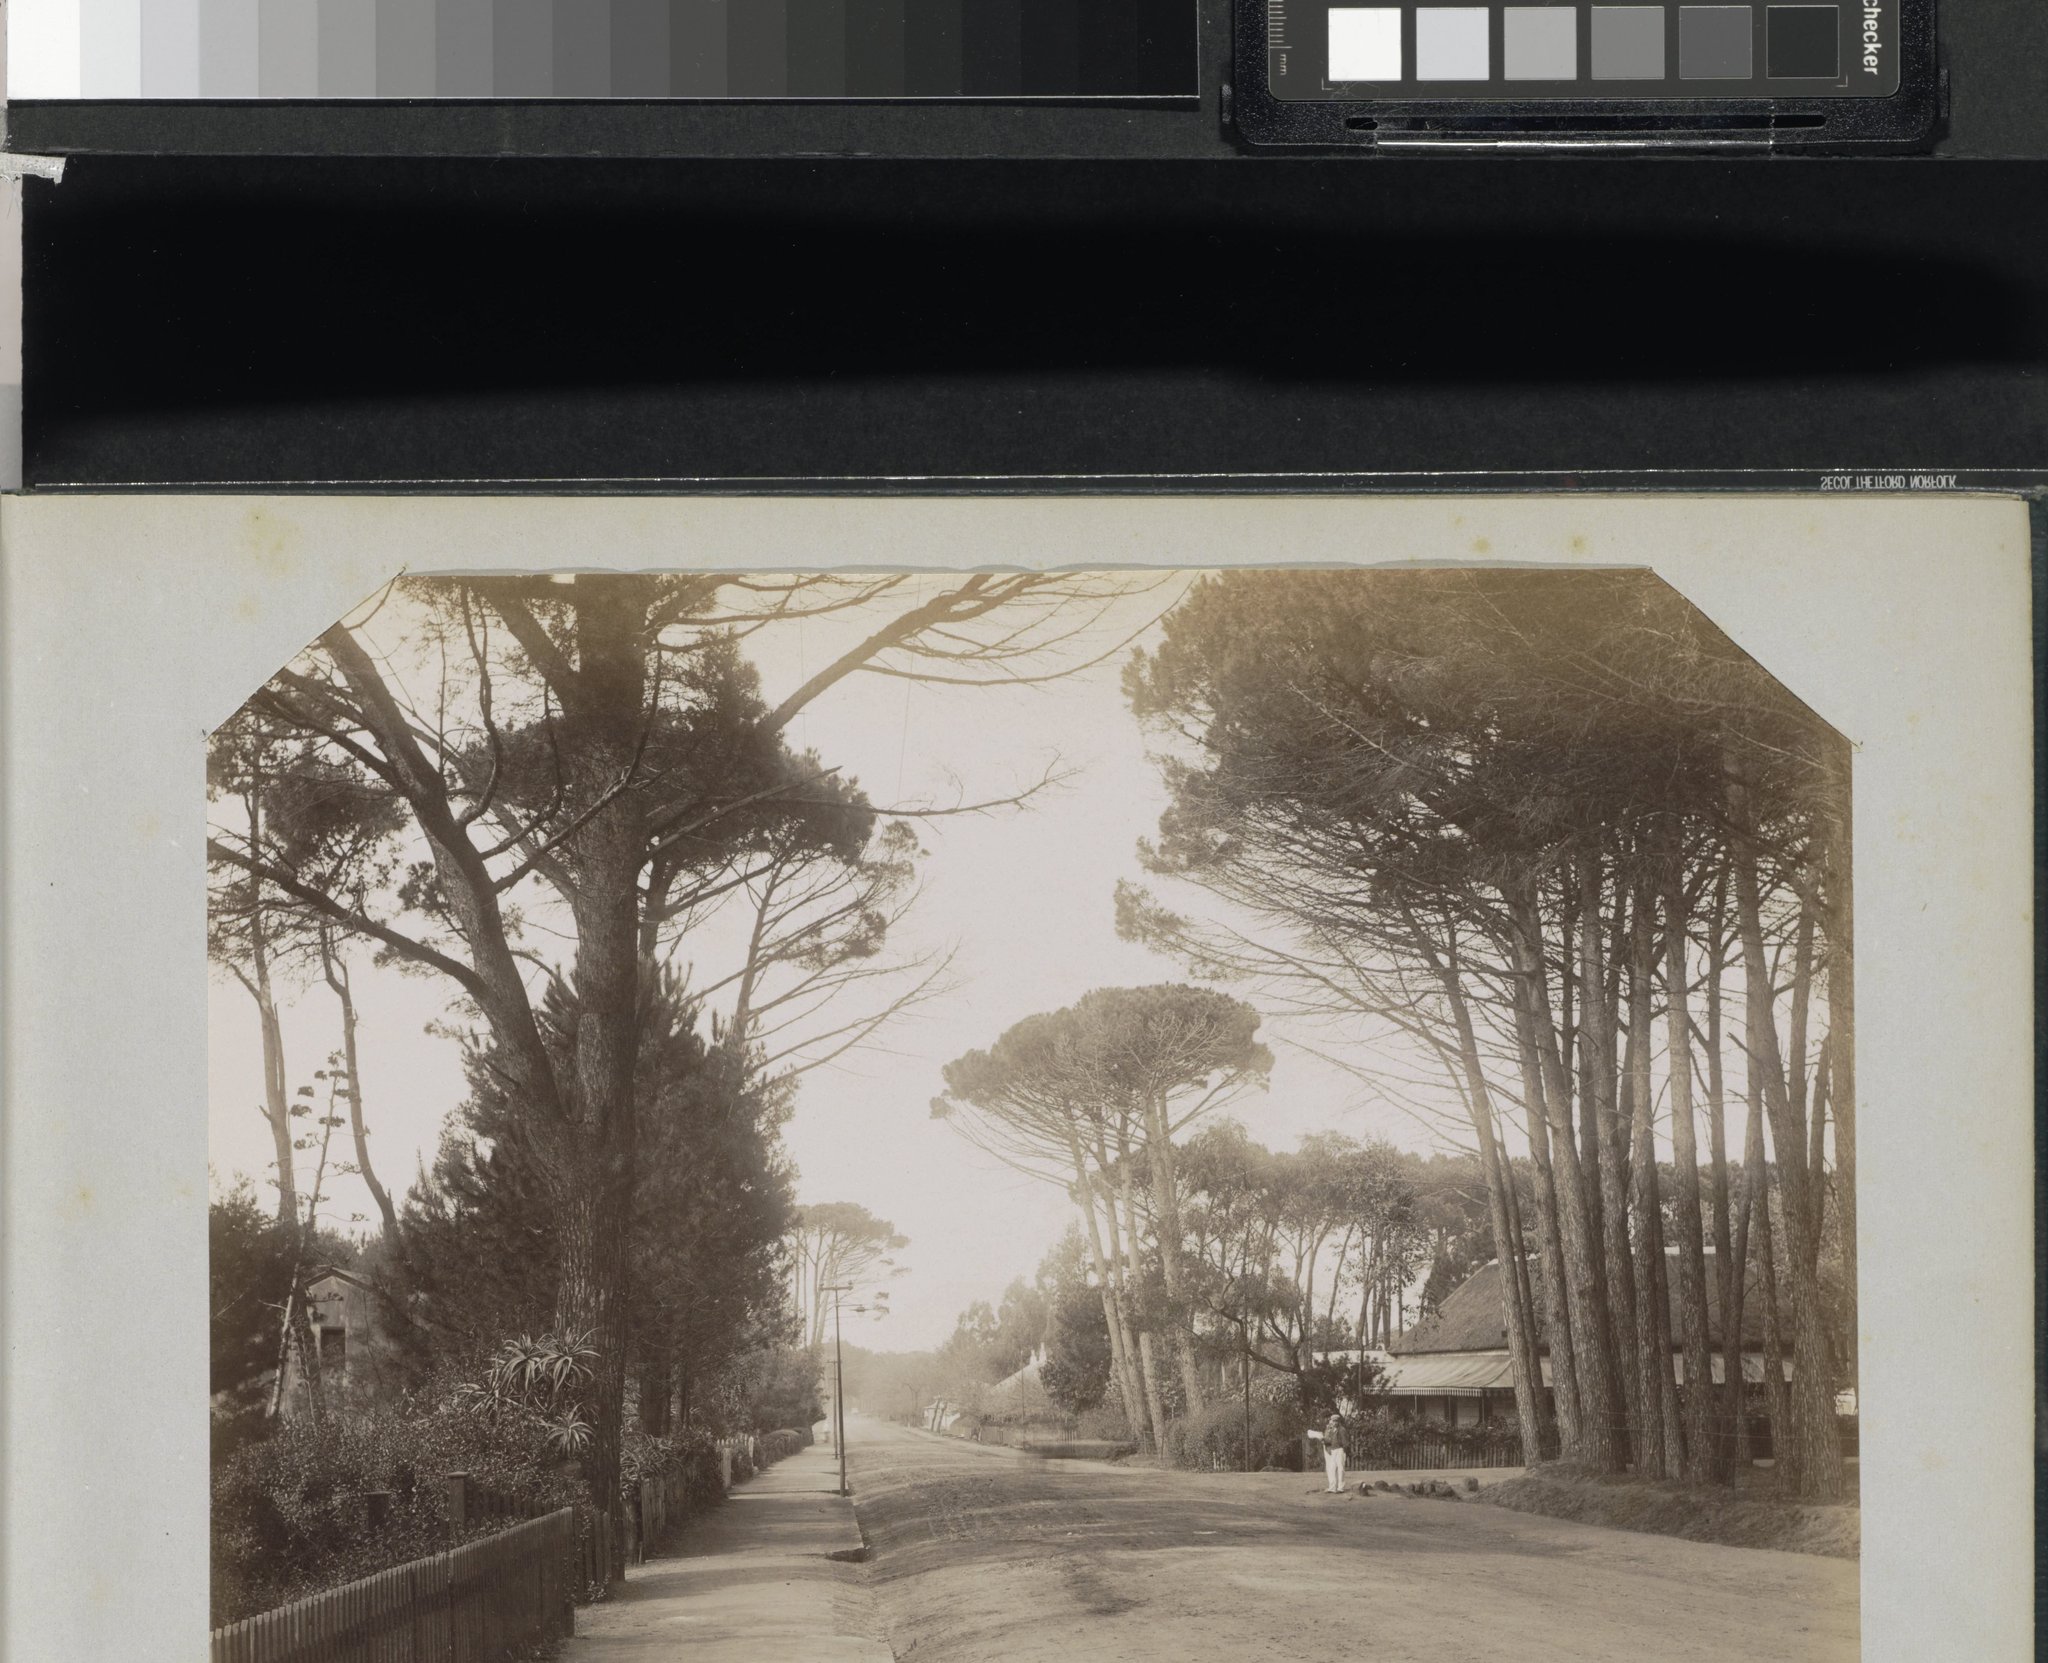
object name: photograph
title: Straatgezicht te Wijnberg, Kaapstad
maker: george washington wilson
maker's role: publisher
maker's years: 1823-1893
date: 1870-1893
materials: photographic support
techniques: albumen print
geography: cape town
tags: street (+ city(-scape) with figures, staffage)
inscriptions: annotation: ‘Wijnberg bij Kaapstad, Jan 1896. April 1896’, inscription: ‘On the Main Road, at Wynberg. 20,067. G.W.W.’